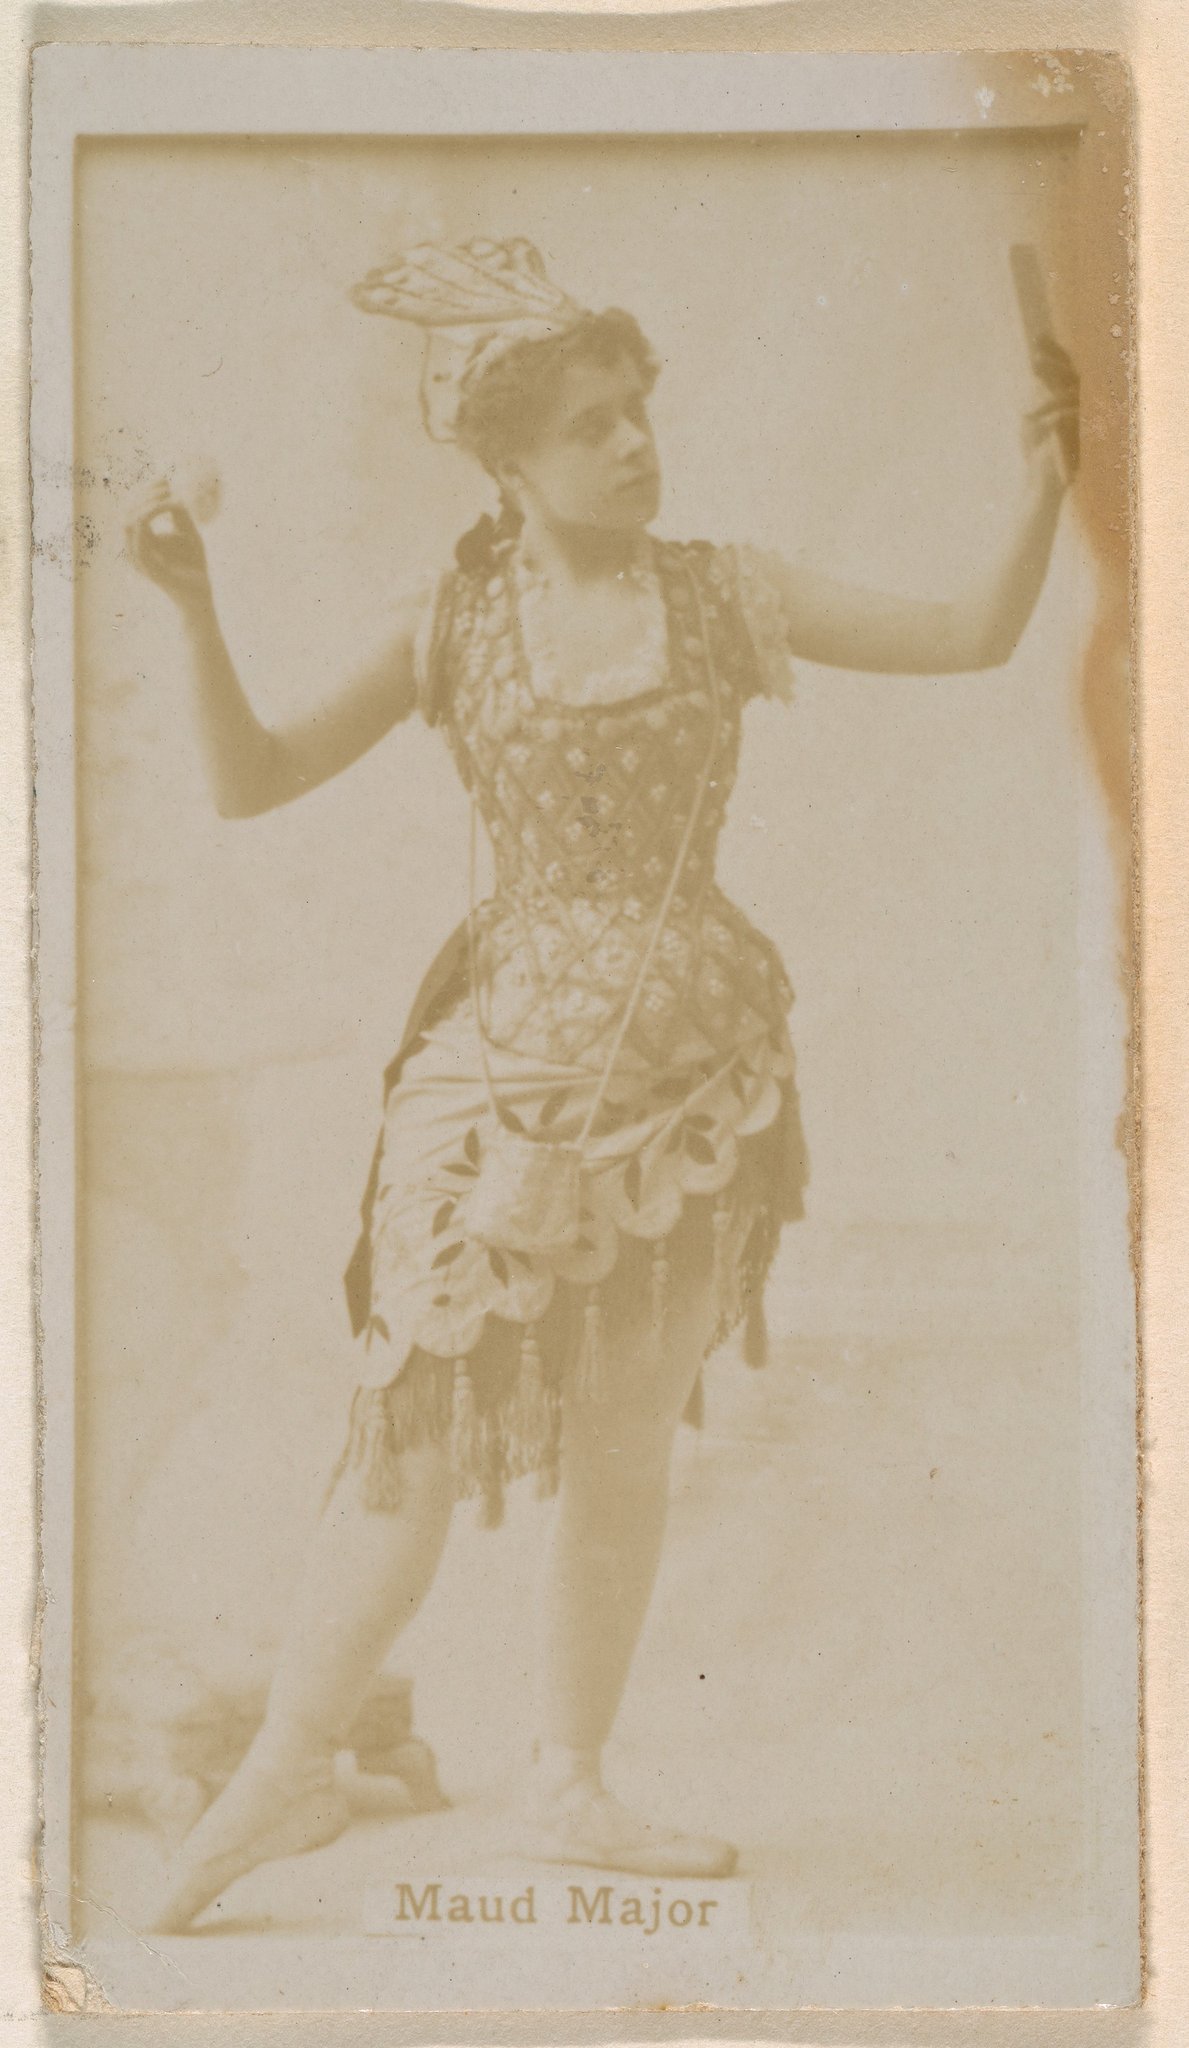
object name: photograph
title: Maud Major, from the Actresses series (N245) issued by Kinney Brothers to promote Sweet Caporal Cigarettes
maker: kinney brothers tobacco company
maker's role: publisher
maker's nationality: american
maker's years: 1869-2011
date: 1890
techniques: albumen silver print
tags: portraits,women,actresses